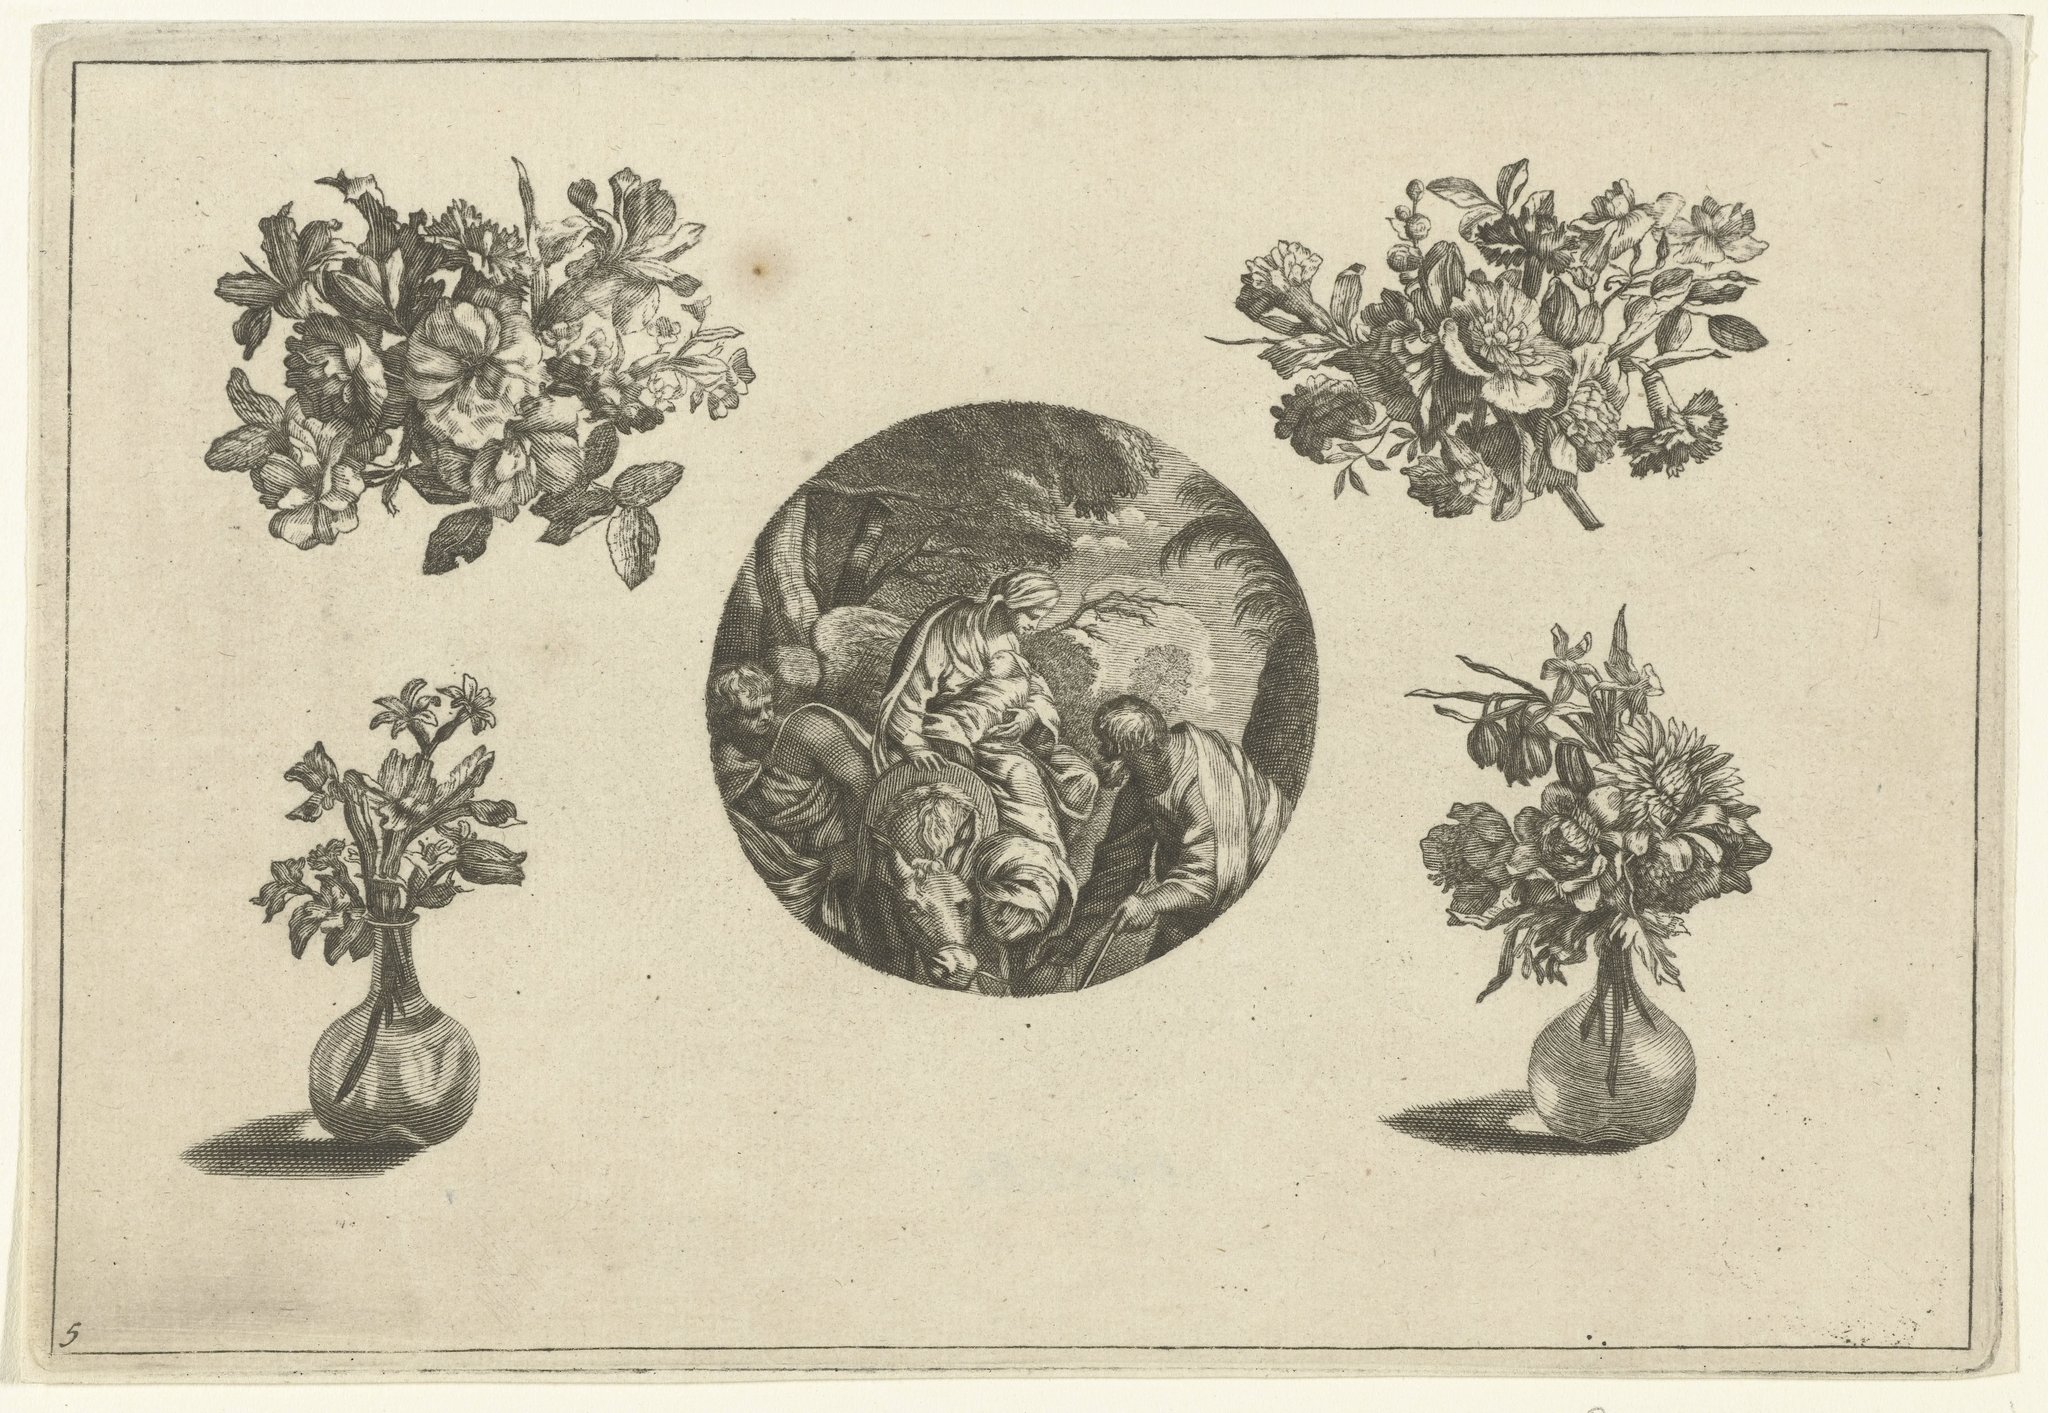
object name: print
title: Horlogekasten: deksels en zijkanten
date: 1661-1726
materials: paper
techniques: engraving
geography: amsterdam